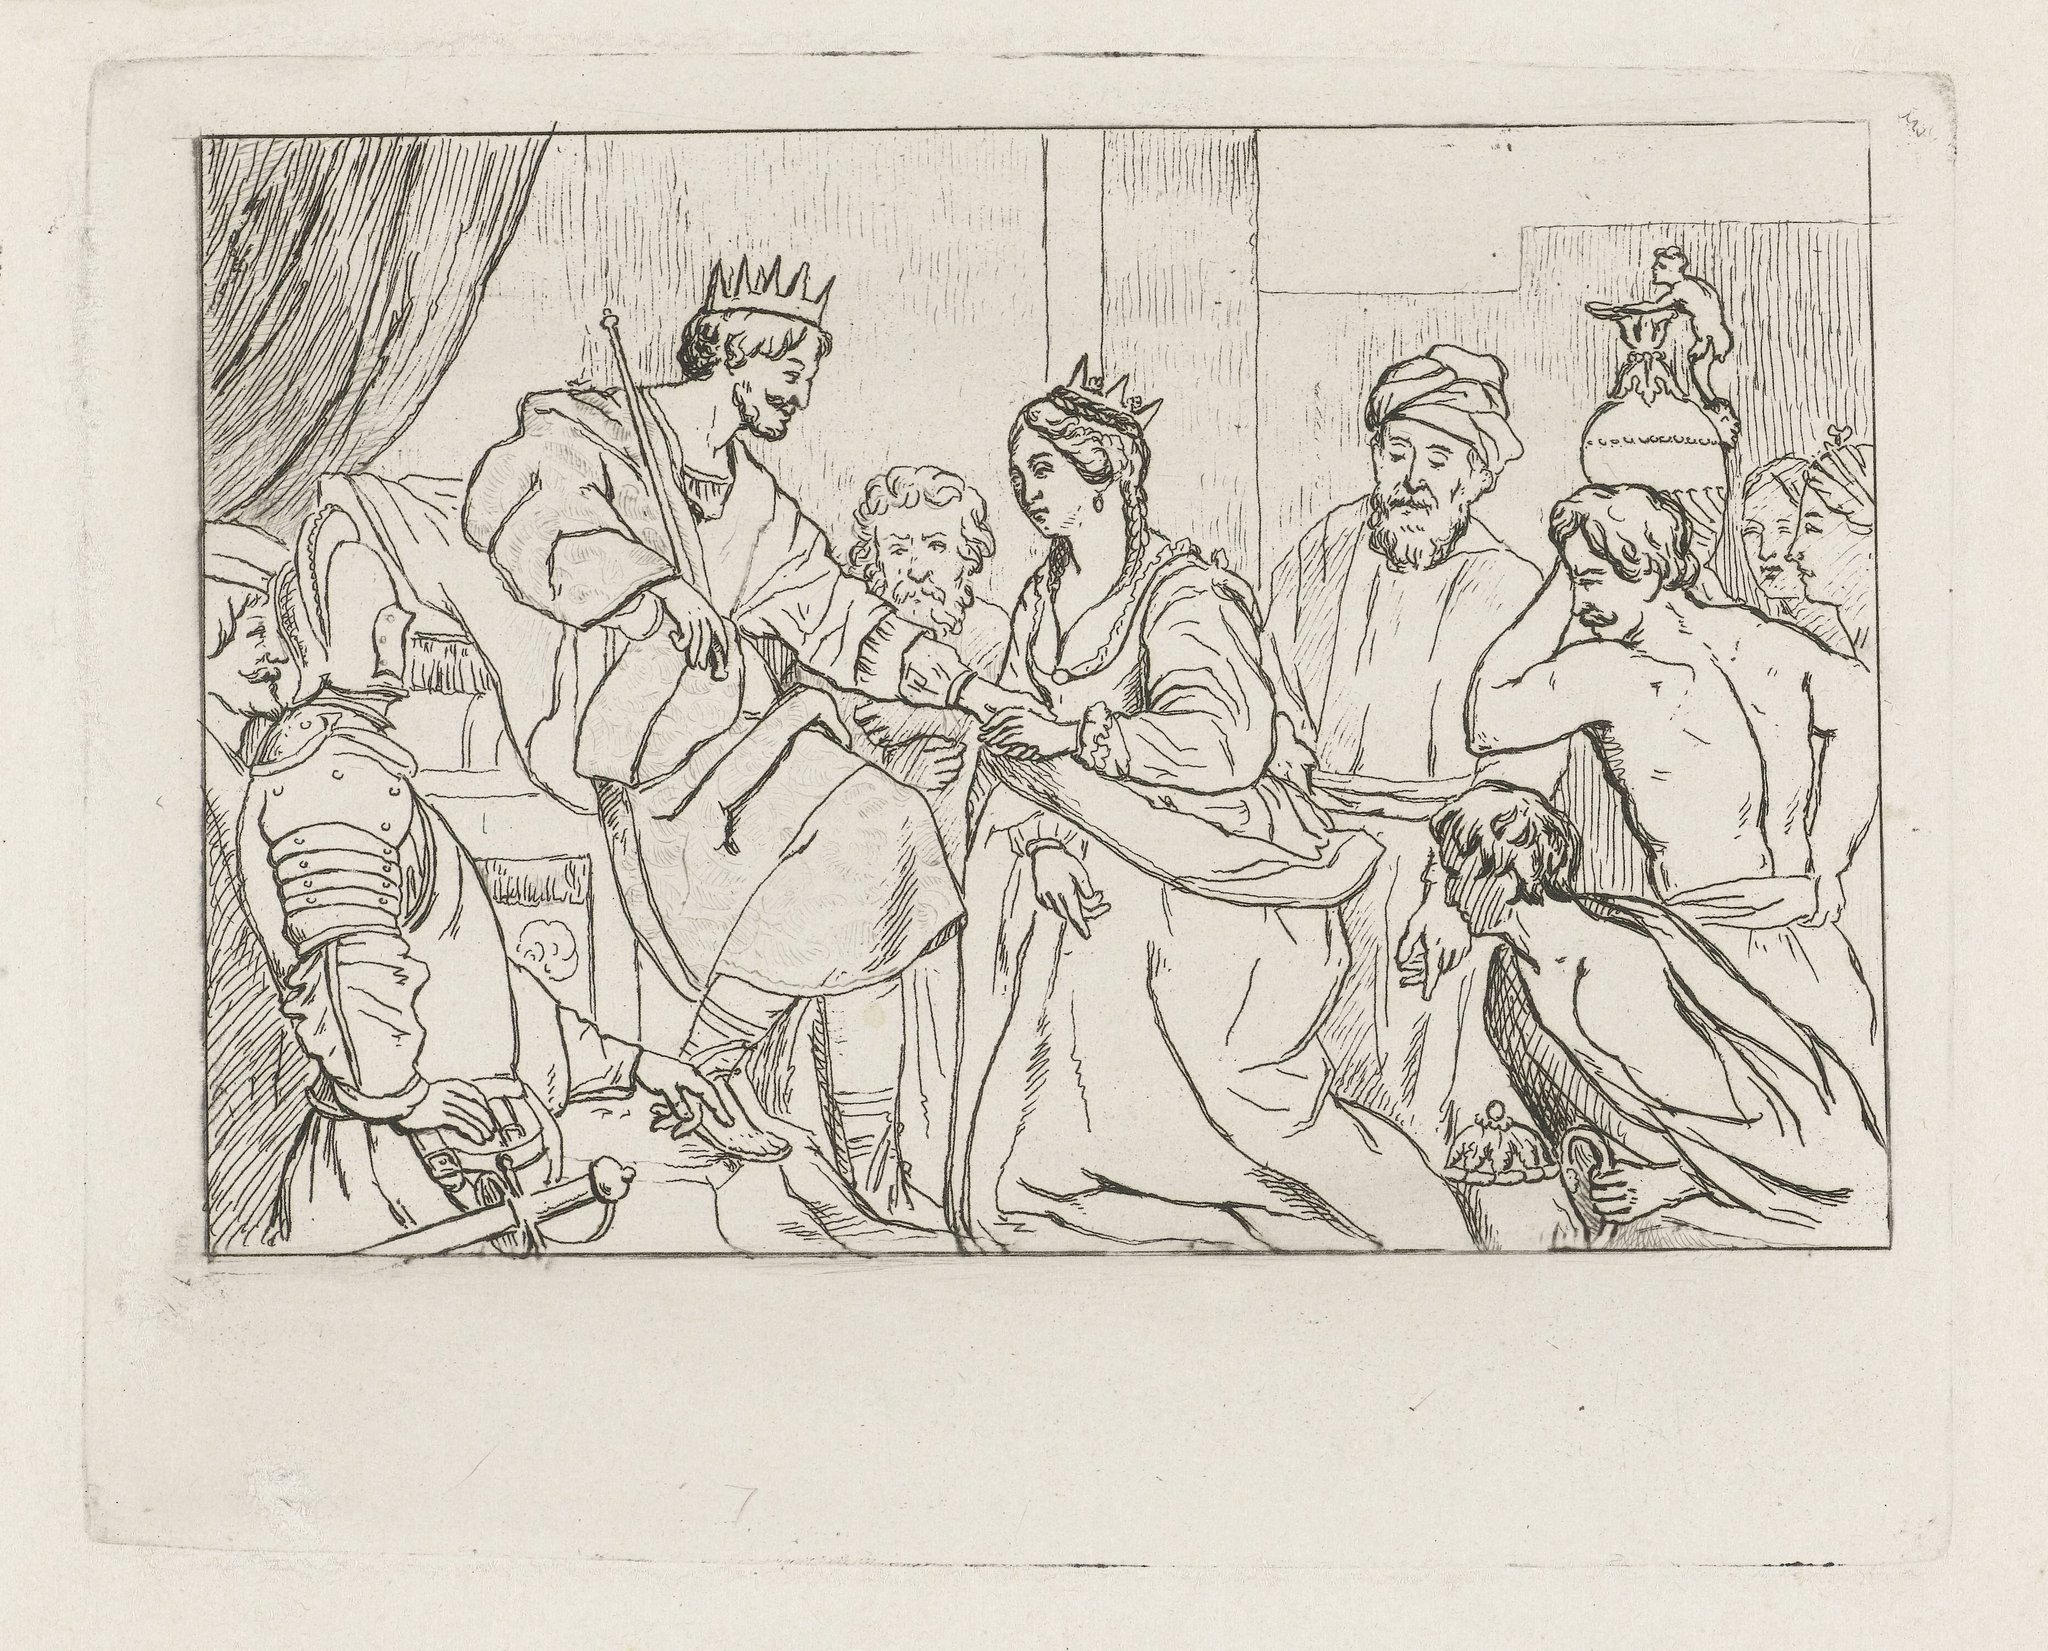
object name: print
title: Salomo en de koningin van Sheba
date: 1814-1879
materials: paper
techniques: etching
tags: homage to solomon: the queen of sheba gives solomon gold, precious stones and spices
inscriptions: collector's mark: Lugt 2228, inscription: ‘Het schilderij was in 1857 op het kasteel Nijenrode te Breukelen en is toen verkocht’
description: De koningin van Sheba, begeleid door haar dienaren, knielt neer voor Salomo die op zijn troon zit. Naast zijn troon staat een lijfwacht.